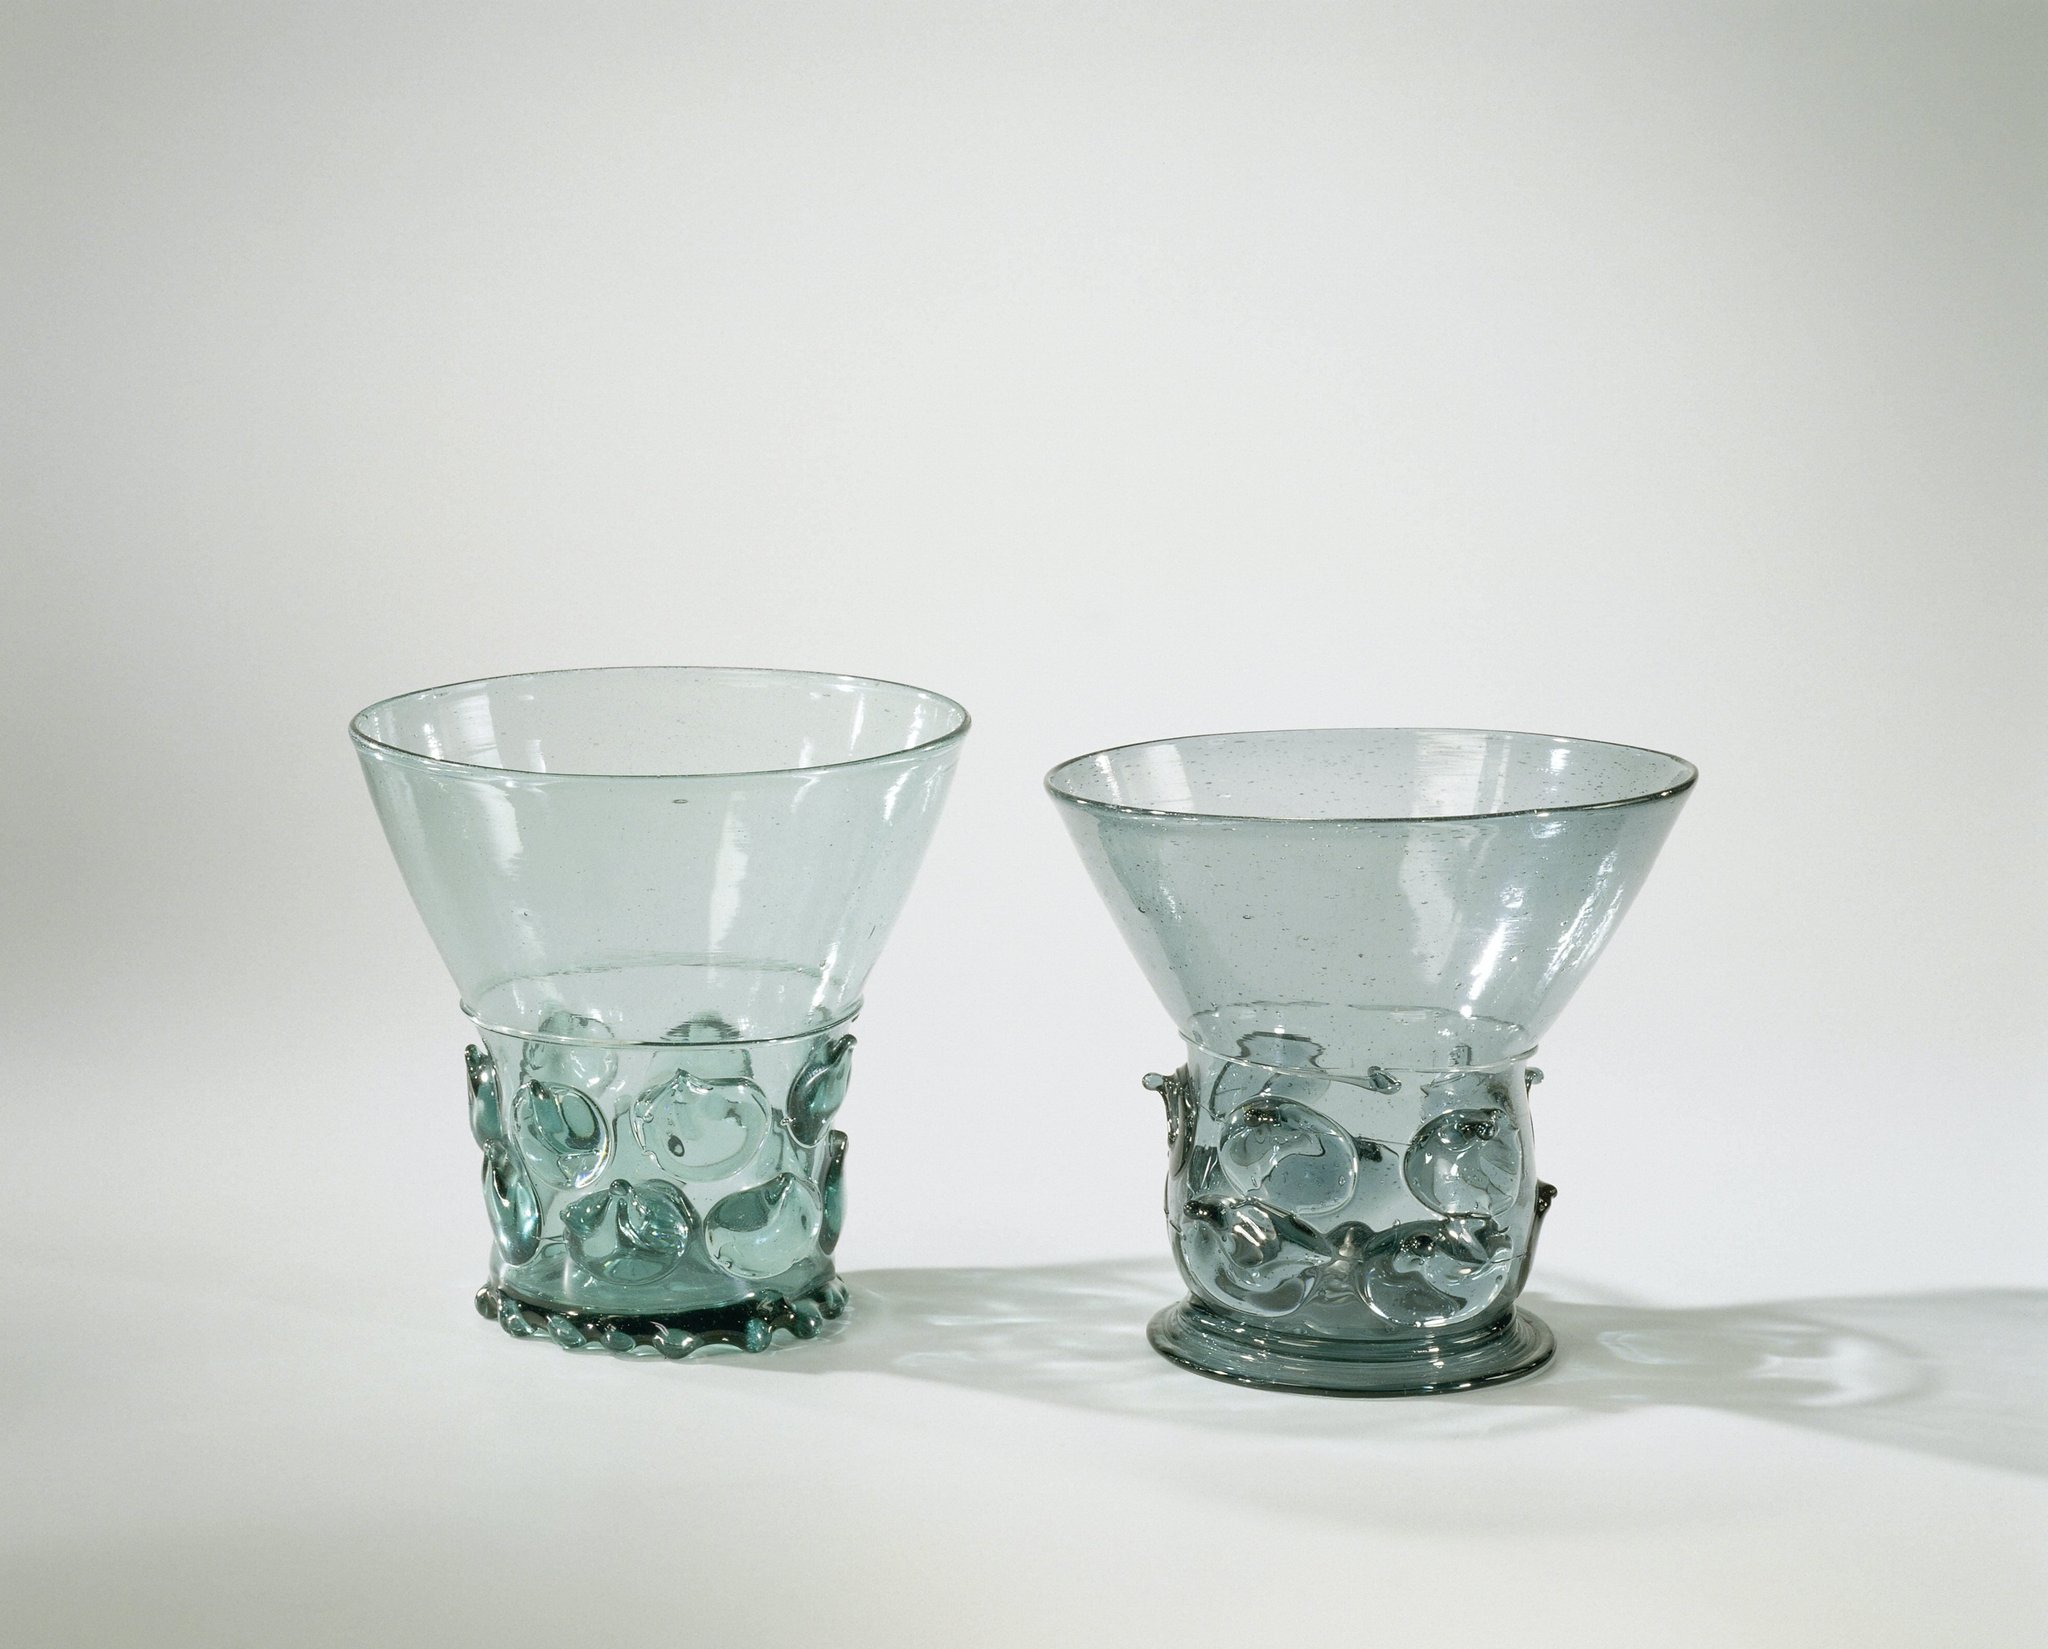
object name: berkenmeier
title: Berkenmeier met twee rijen doornnoppen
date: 1625-1675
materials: glass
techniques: glassblowing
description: Berkenmeier van blauw glas, met ingestoken bodem op een platte uit draad gesponnen voet. De trechtervormige kelk stam als één geheel geblazen met de stam, die bezet is met twee rijen doornnoppen. De overgang van de kelk naar de stam aangegeven door een gladde draad